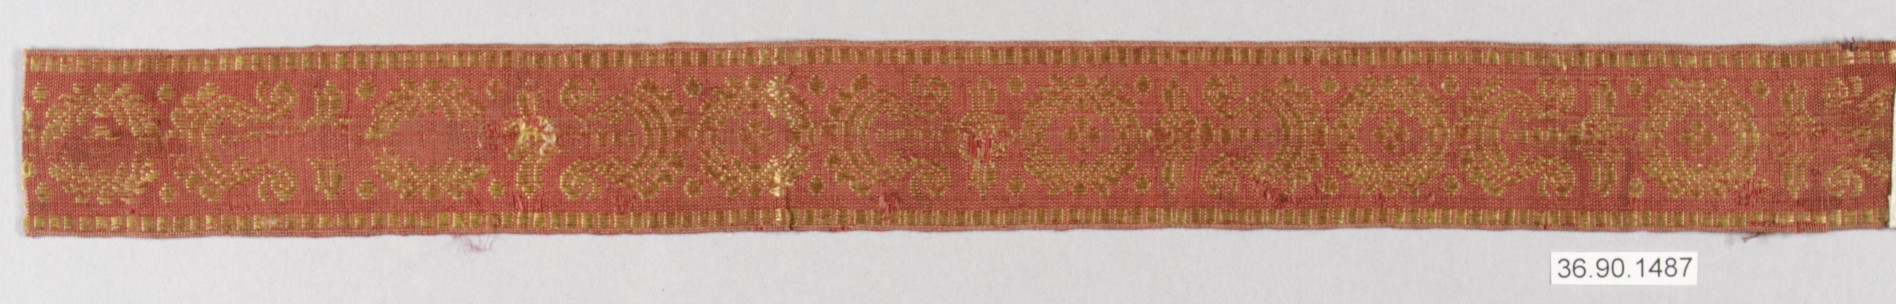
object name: ribbon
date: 1801-1900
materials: silk